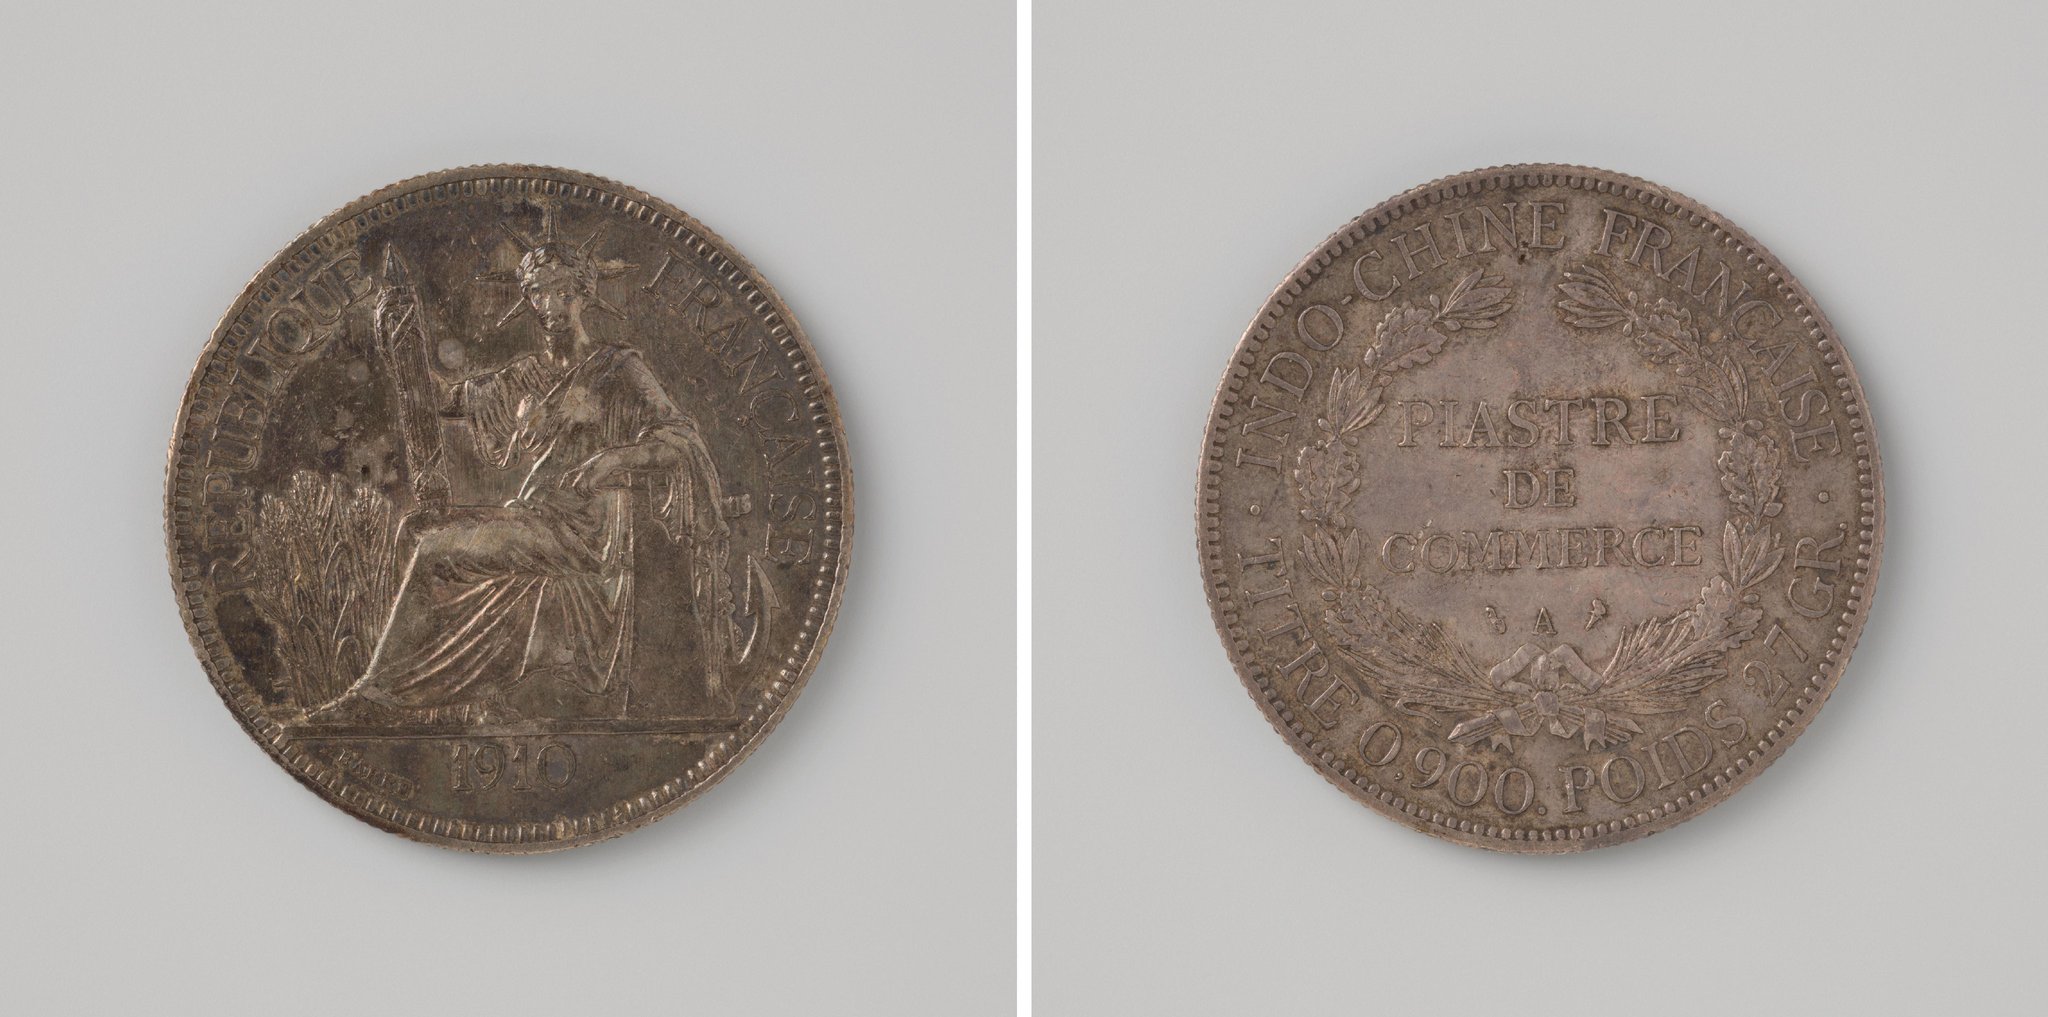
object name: coin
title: Frans Indo-China, piastre, 1910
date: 1910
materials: silver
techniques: striking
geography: paris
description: Zilveren munt. Voorzijde: vrouw met stralenkrans rond haar hoofd in zetel naar links met in haar rechterhand pijlenbundel. Links van haar takken en rechts anker. In afsnede jaartal. Keerzijde: tussen twee samengebonden takken in drie regels waarde-aanduiding: piastre de commerce, waaronder letter A [=Parijs]. In omschrift onderaan gehalte- en gewichts-aanduiding. Kartelrand.